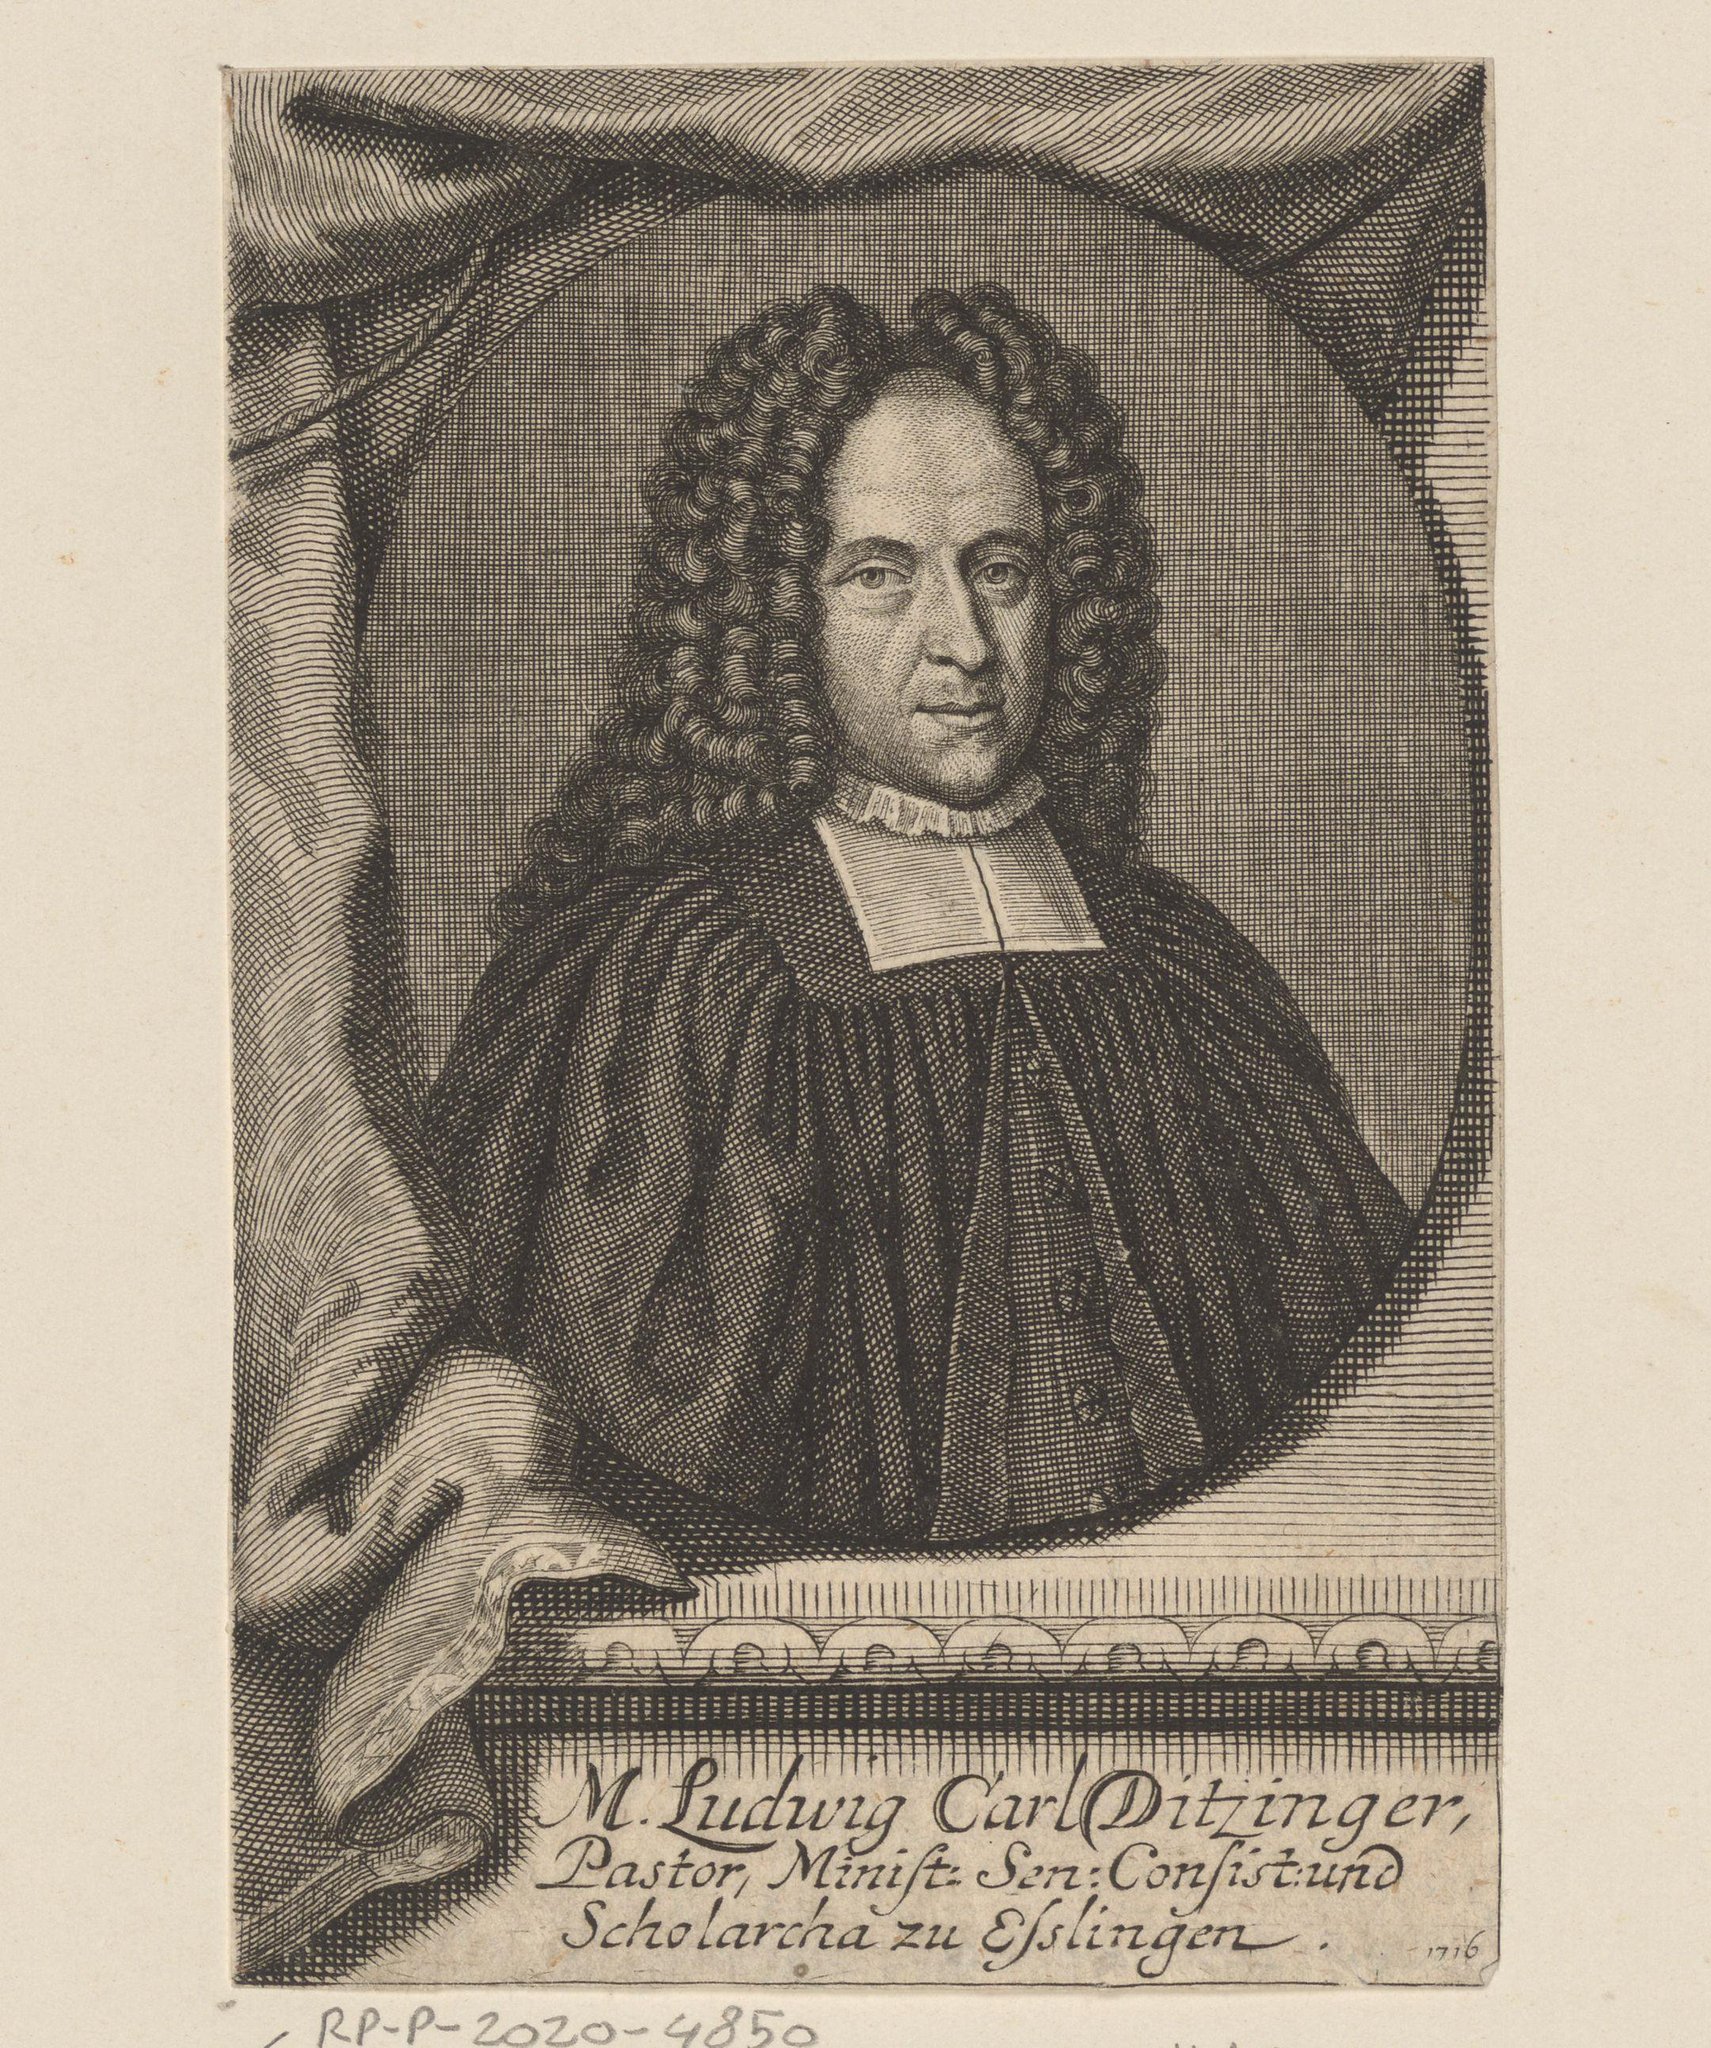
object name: print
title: Portret van Ludwig Carl Ditzinger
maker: johann georg mentzel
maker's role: print maker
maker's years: 1677-1743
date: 1716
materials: paper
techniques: engraving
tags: theologian, historical persons